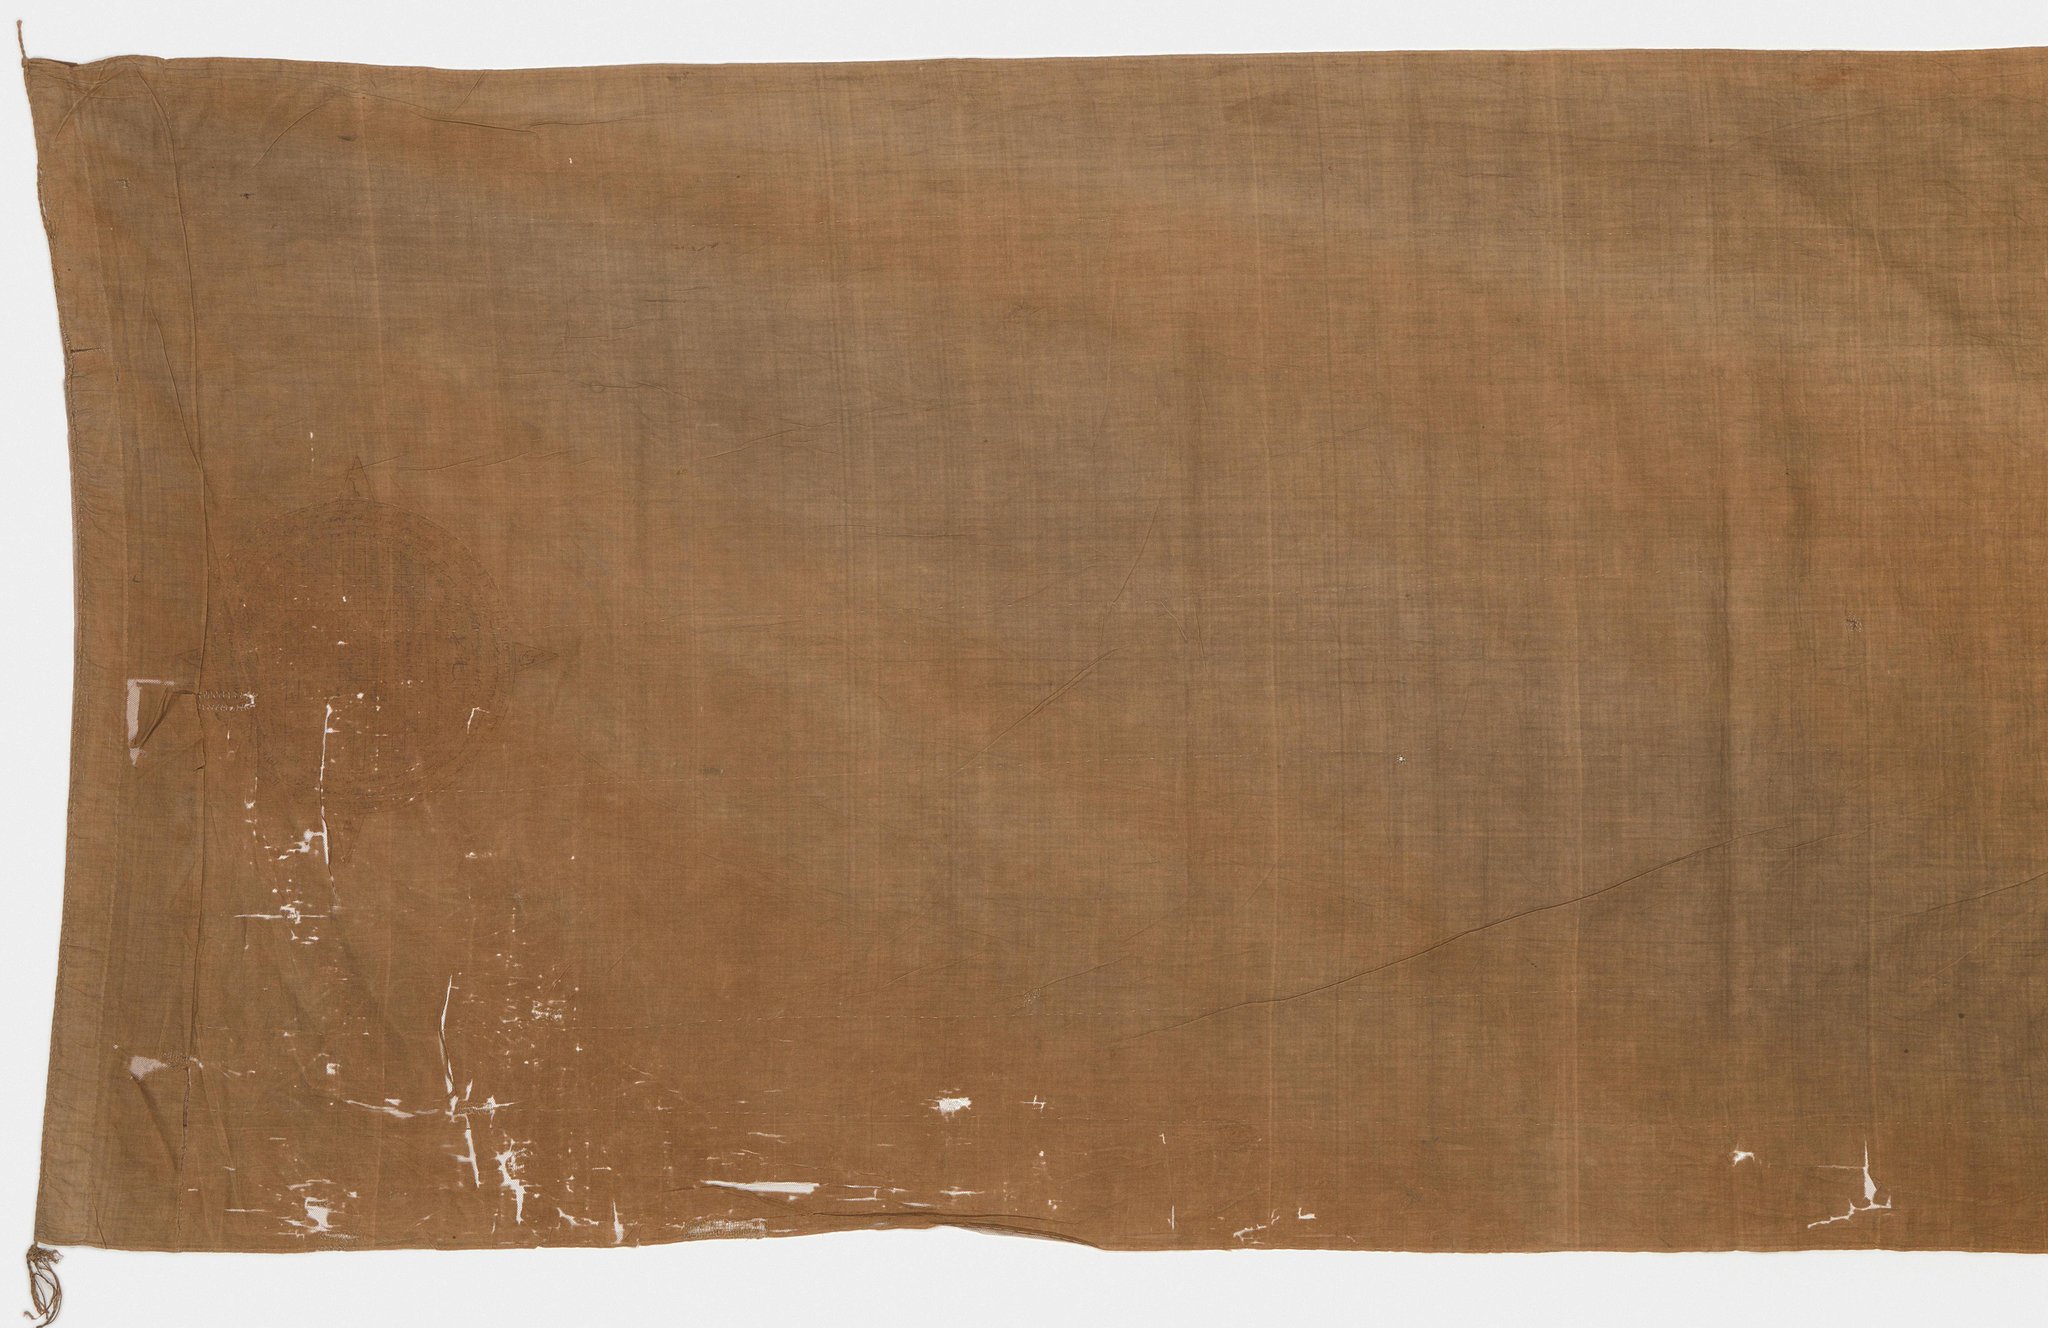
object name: flag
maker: Anonymous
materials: linen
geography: indonesian archipelago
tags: flag, colours (as symbol of the state, etc.)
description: Deze en MC-1125-A en C werden door het schroefstoomschip Reteh (6 stukken, oorspronkelijk de Sprinkhaan, lang 43 m, gebouwd te Amsterdam in 1858-1860, niet meer vernoemd vanaf 1872) veroverd op piraten die zich verschanst hadden op een eilandje in de baai van Lobo. Het eiland is Jolly-eiland genoemd, naar Ltz. H.L. Jolly die bij deze actie het leven verloor.